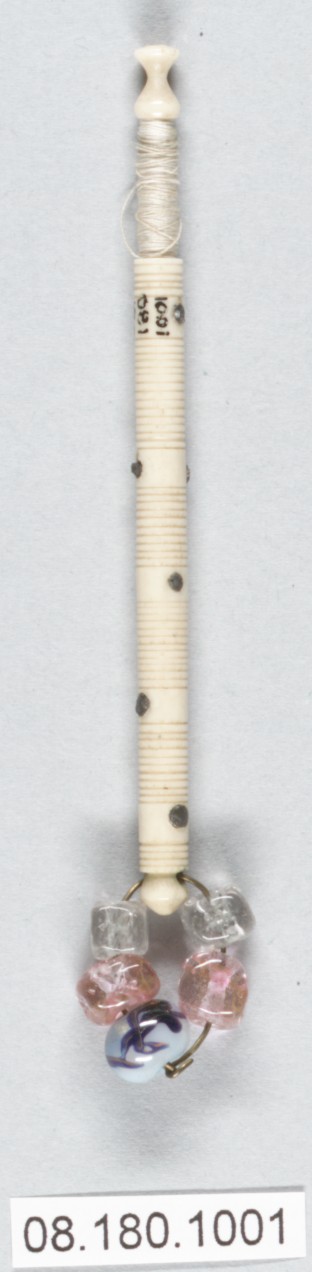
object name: bobbin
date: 1801-1900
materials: bone, metal